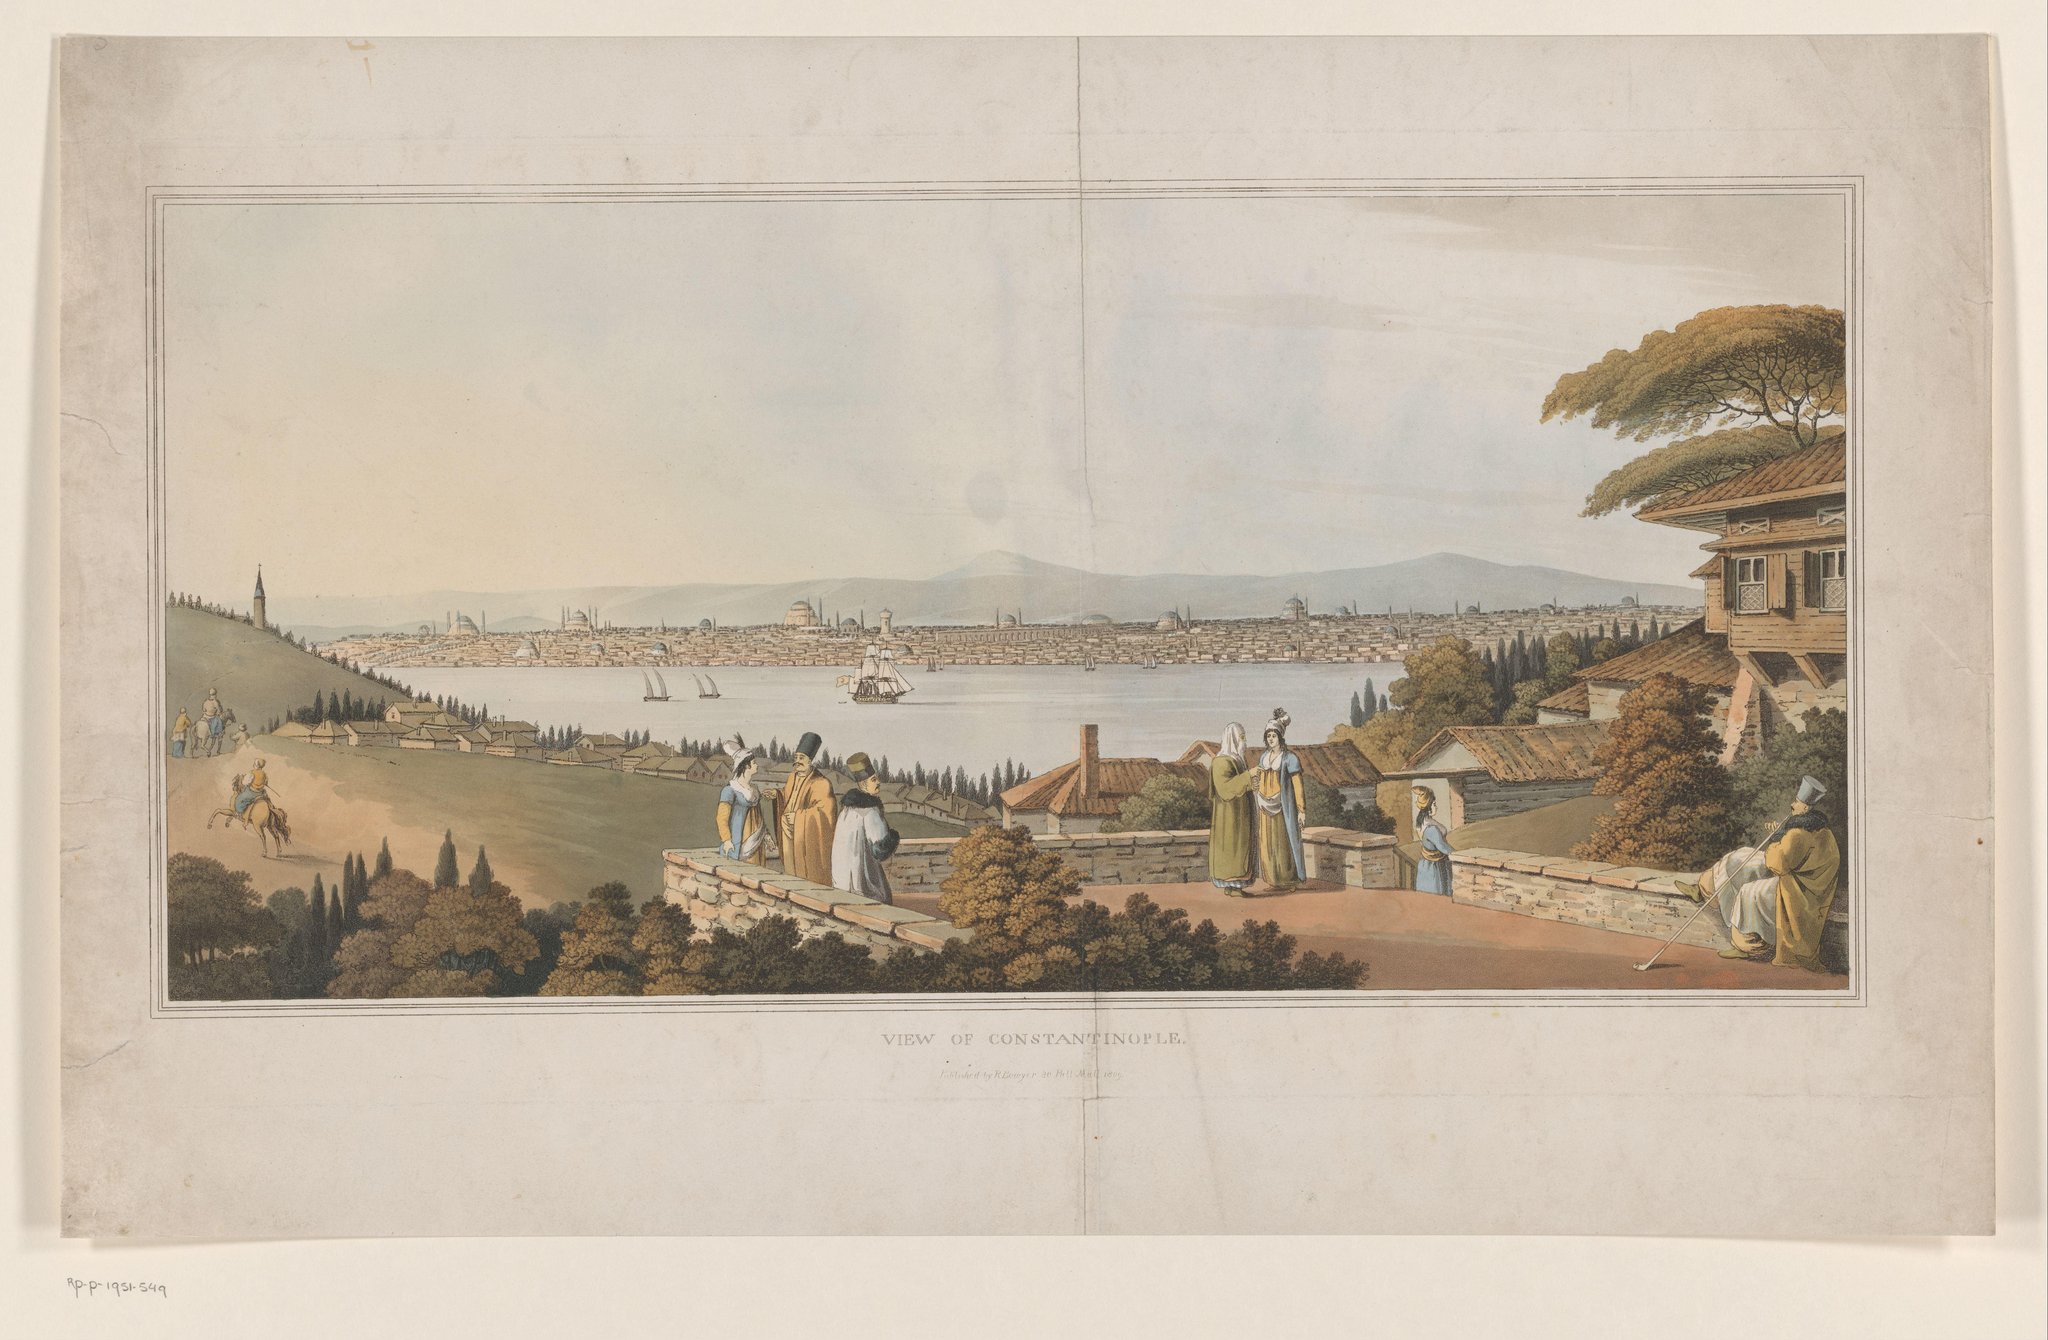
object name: print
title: View of Contantinople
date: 1809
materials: paper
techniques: aquatint, etching, hand coloring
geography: london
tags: city-view, and landscape with man-made constructions, opium-pipe, temple, shrine ~ islam, mohammedanism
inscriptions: collector's mark: Lugt 2228